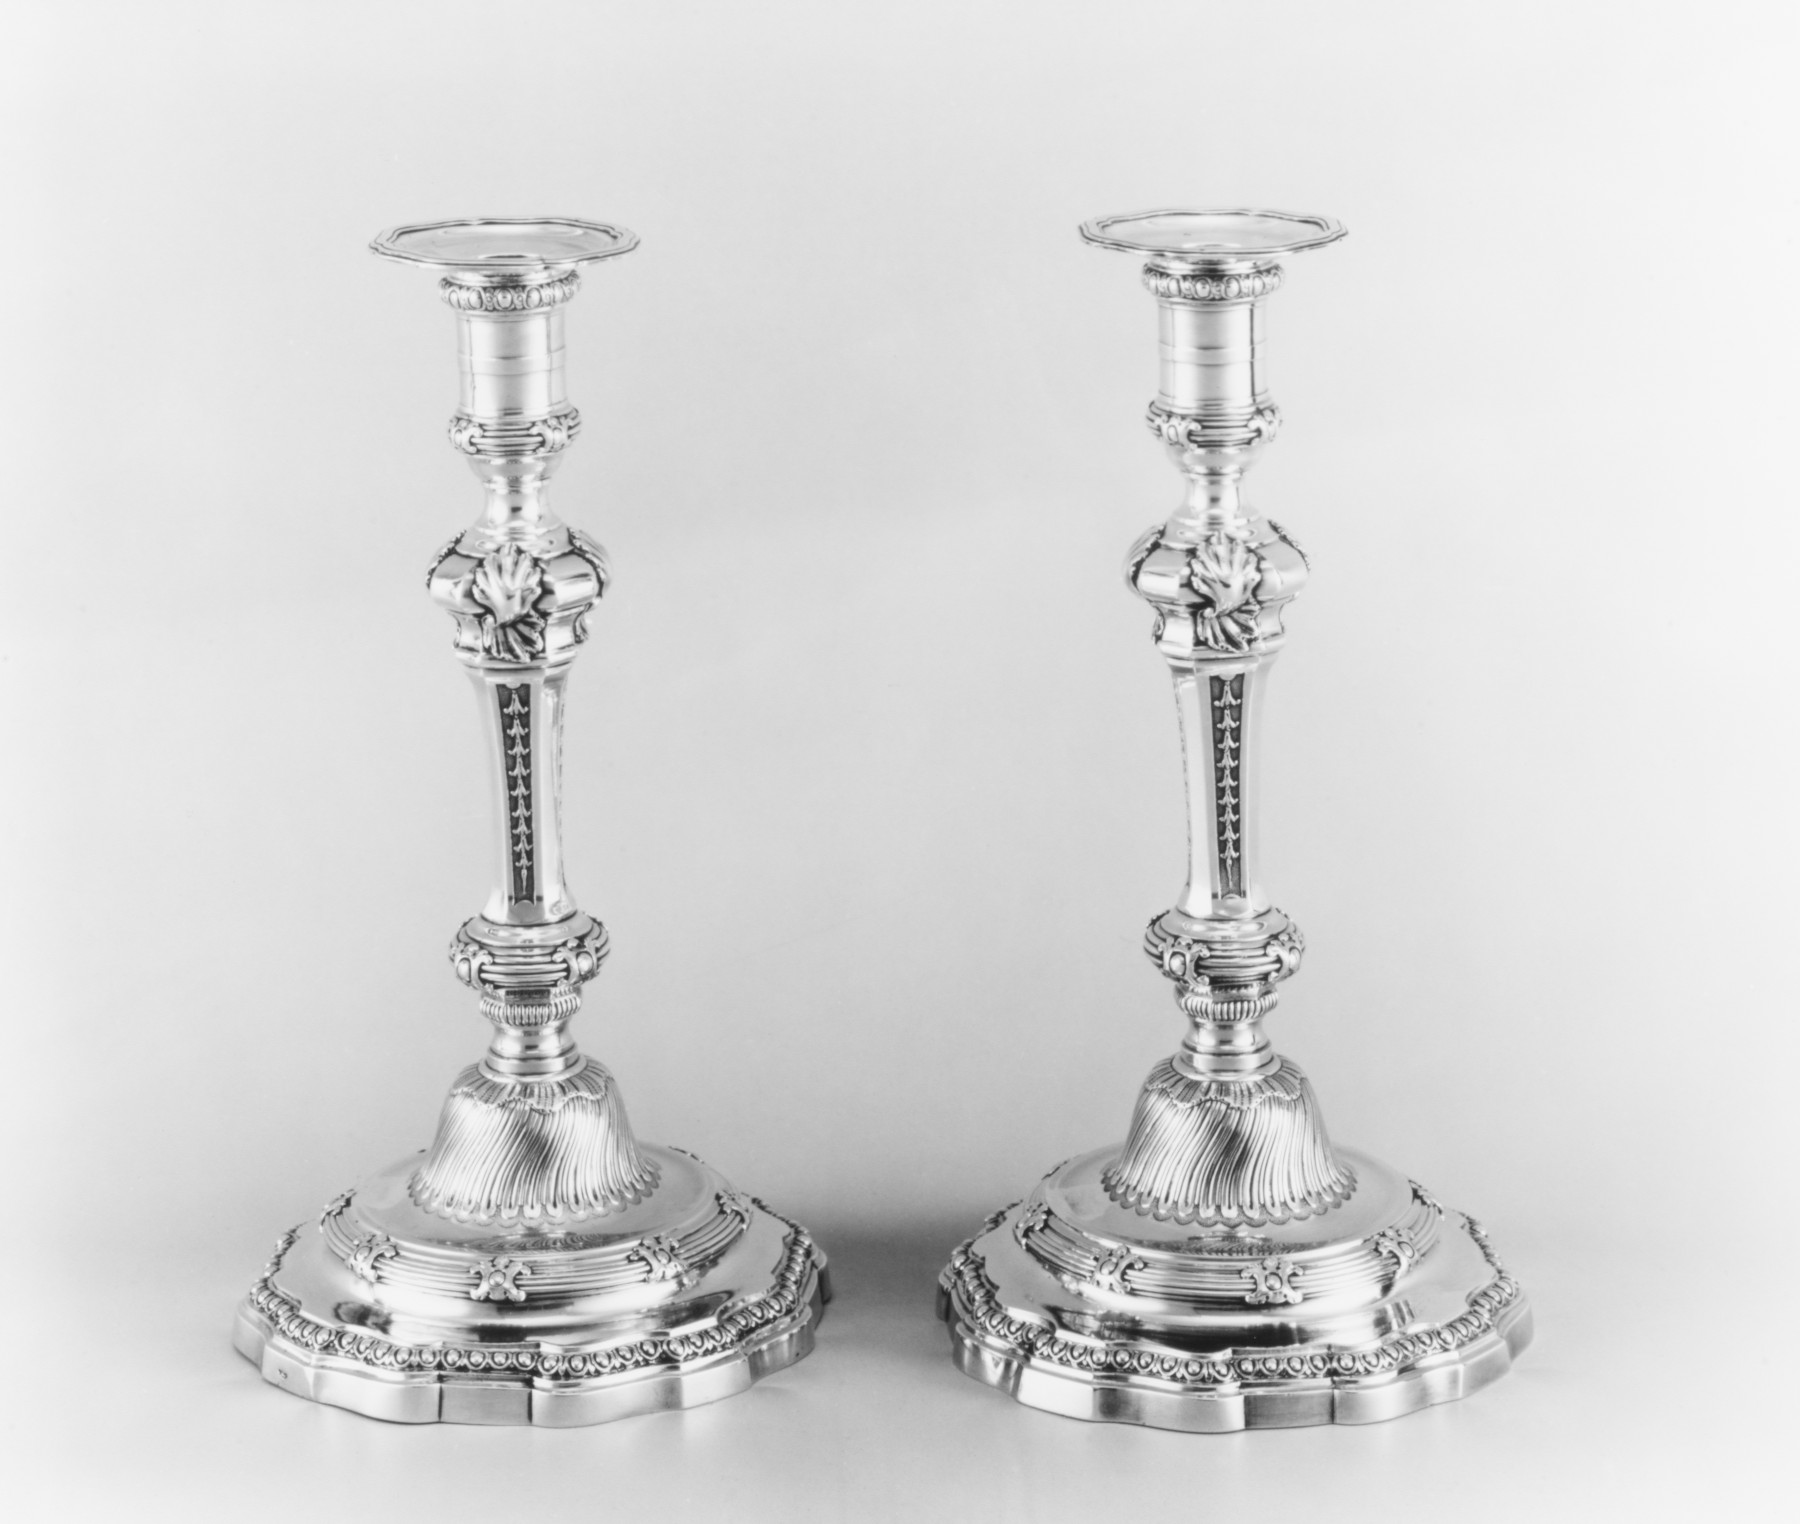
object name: candlestick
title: Pair of candlesticks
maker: alexis iii loir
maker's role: maker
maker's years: 1675-1775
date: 1748-1749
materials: silver